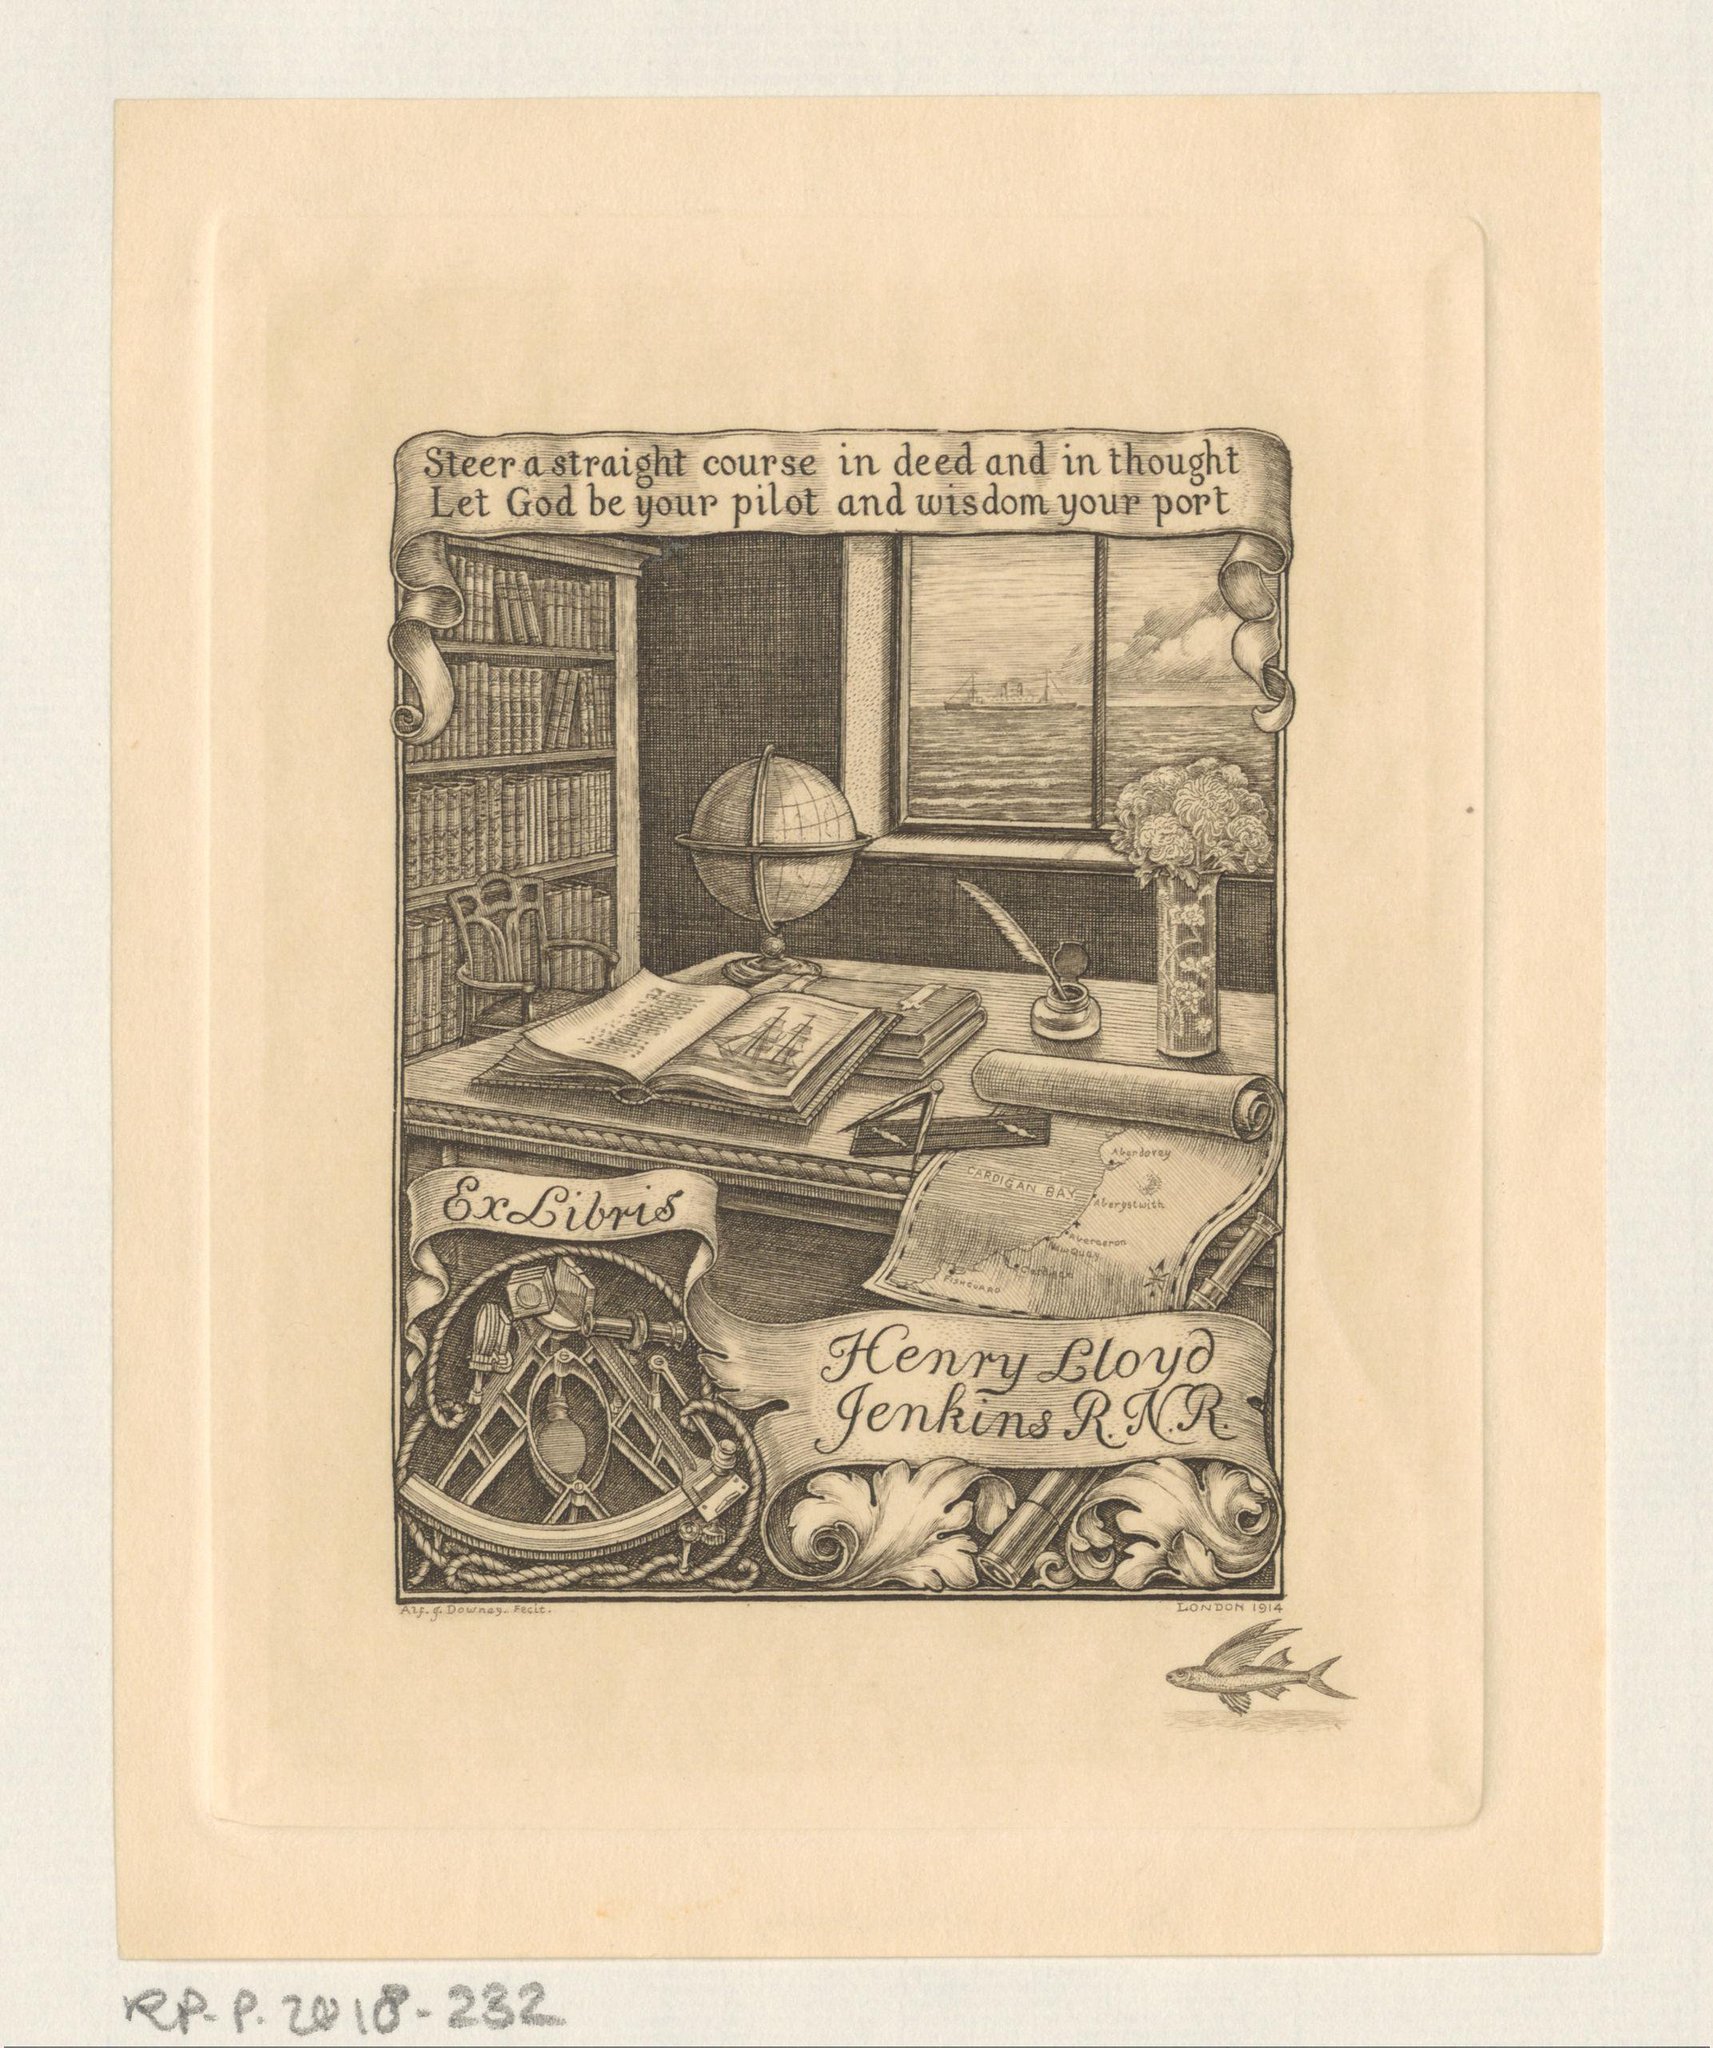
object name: bookplate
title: Steer a straight (...) wisom your port.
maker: alfred james downey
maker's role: print maker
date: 1914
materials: paper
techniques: engraving, etching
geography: england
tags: bookshelves, view through a window, ships (in general), book, globe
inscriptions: date